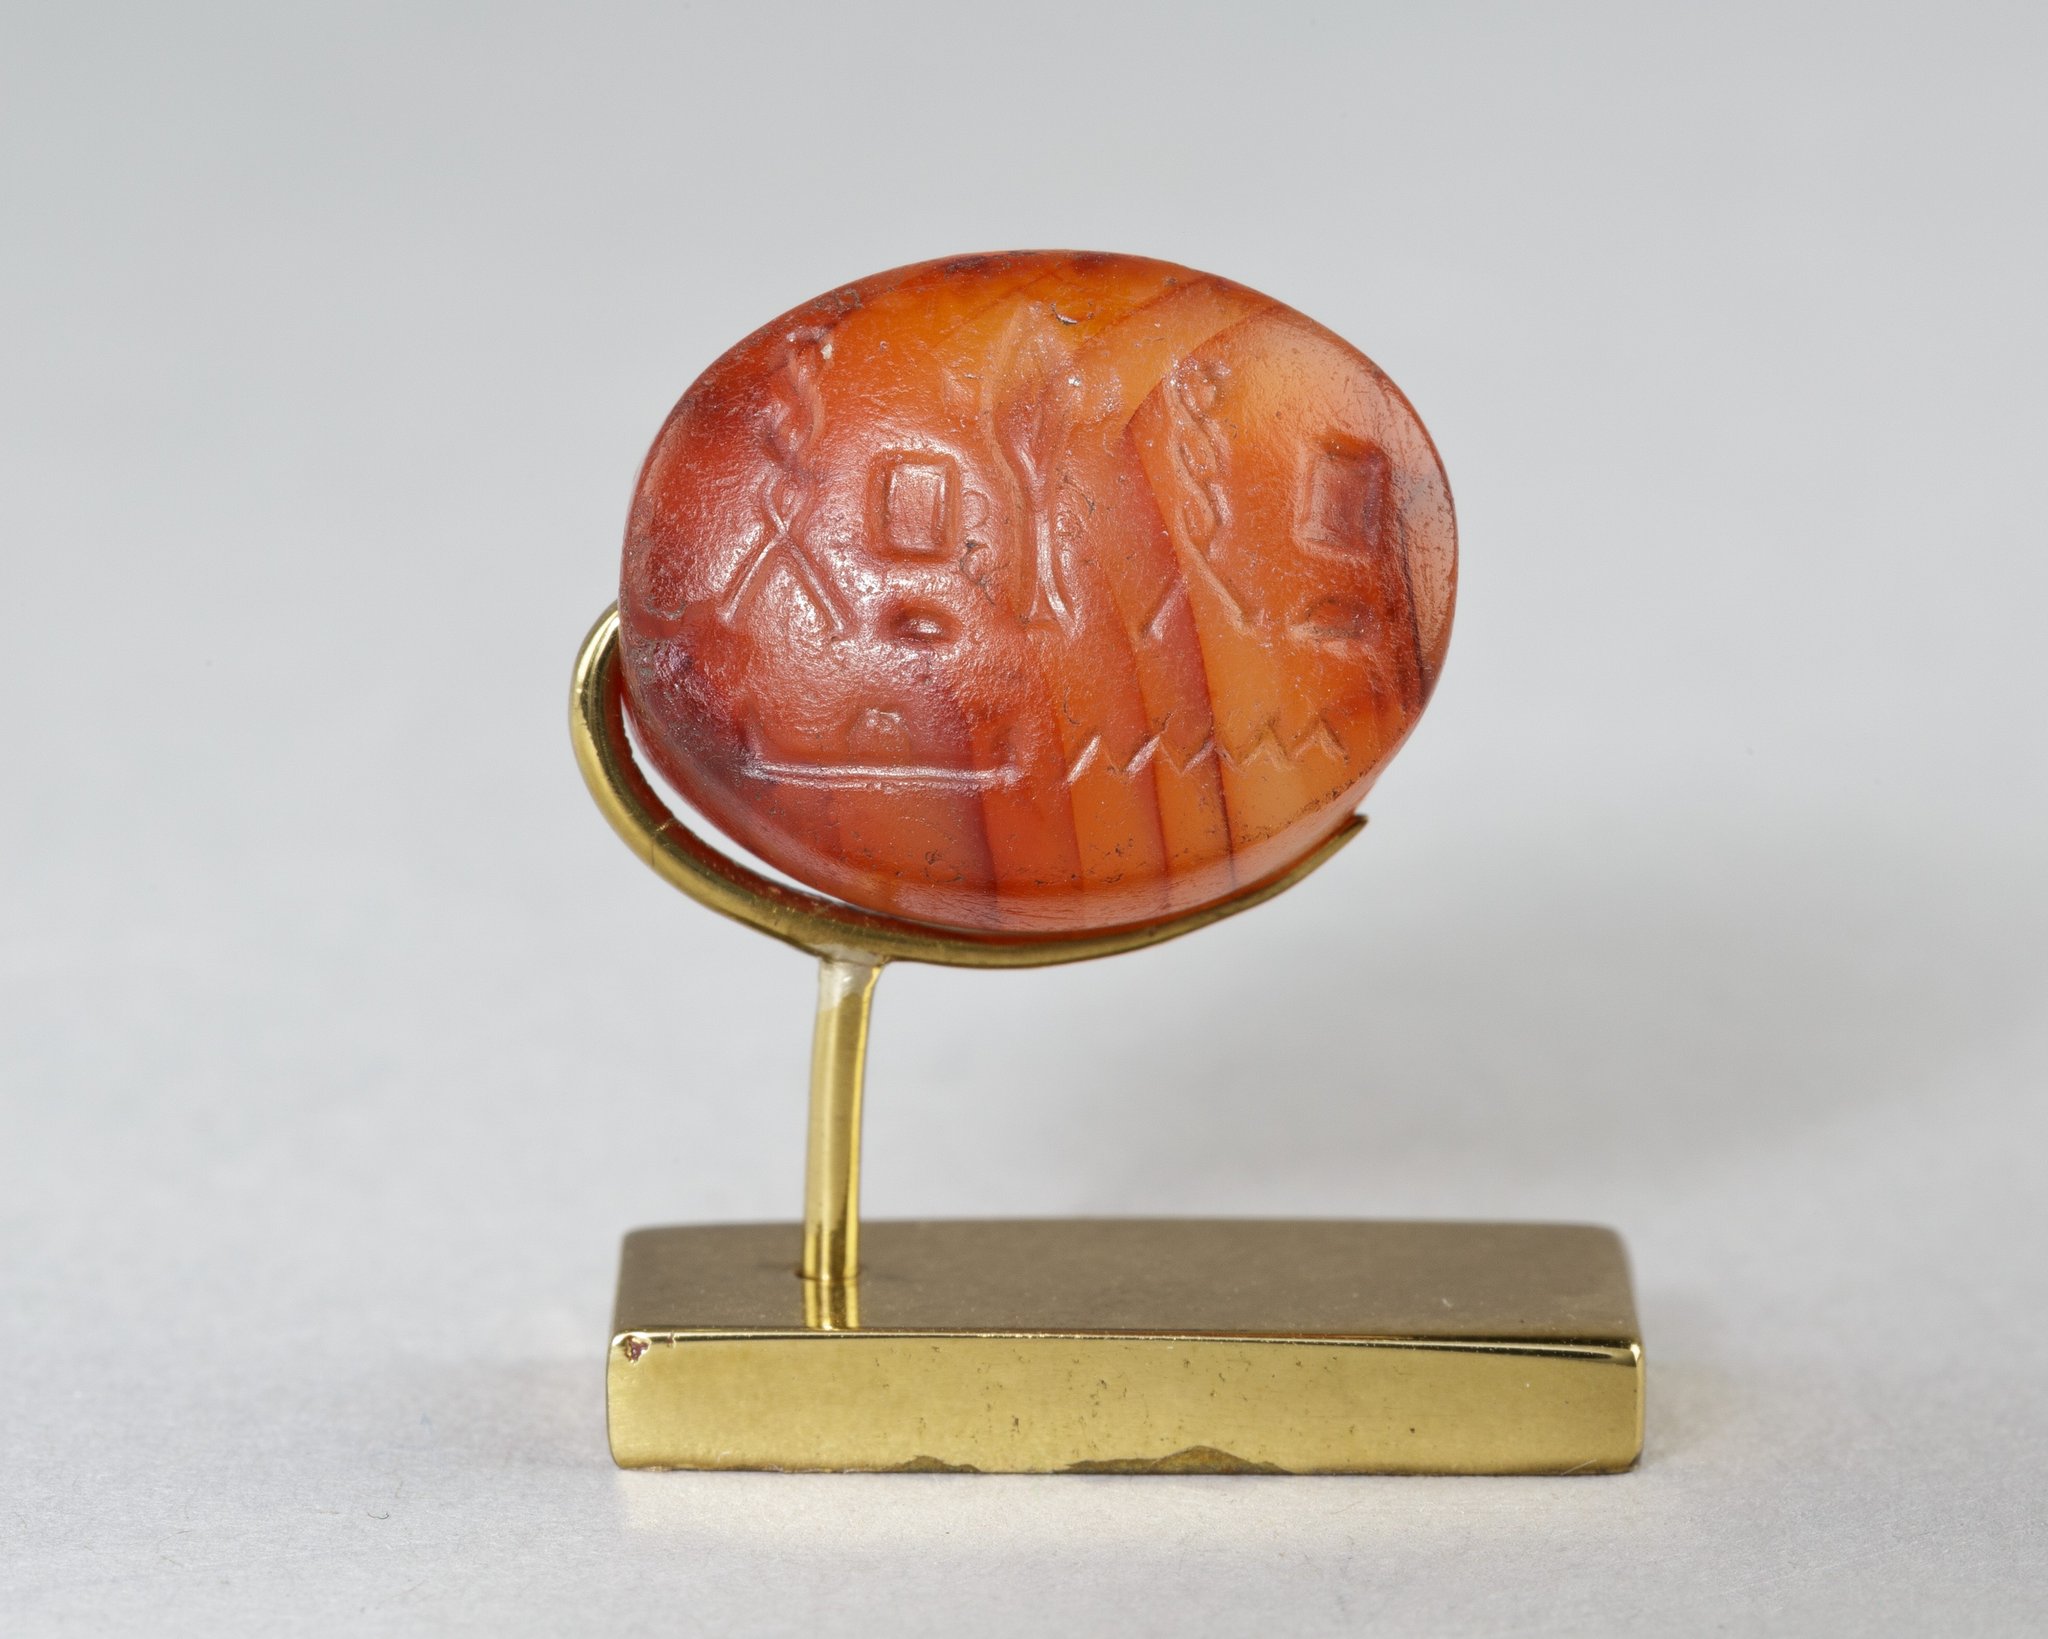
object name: scarab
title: Scaraboid Bead with a device referring to Ptah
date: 664-332 BCE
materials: gemstone, jasper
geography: egypt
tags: hieroglyphs